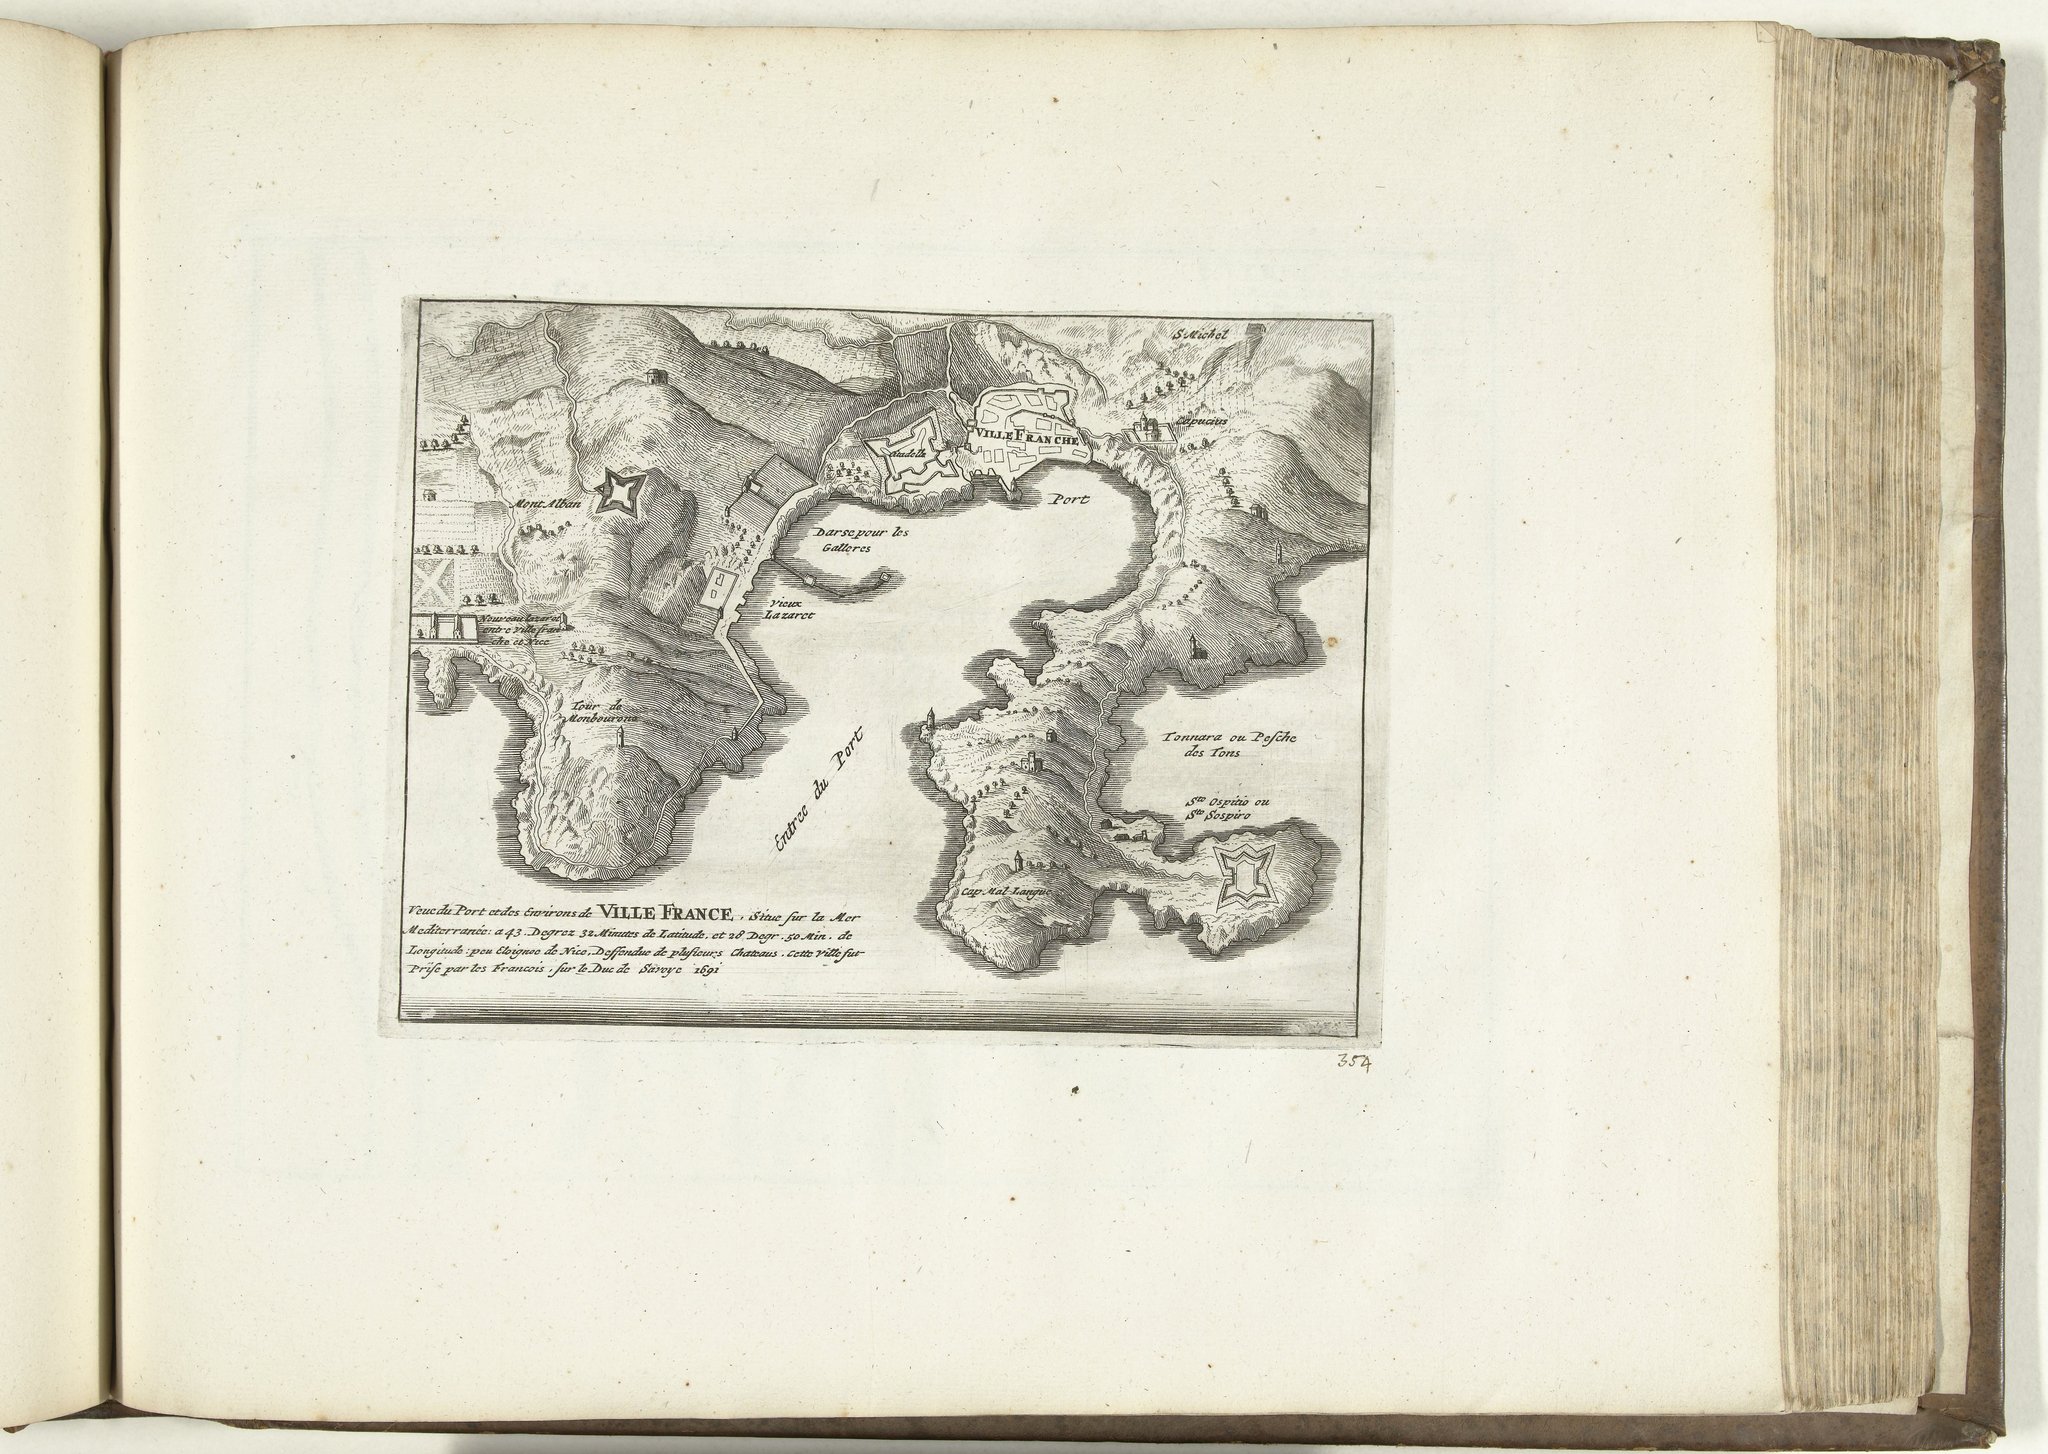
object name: print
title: Kaart van Villefranche-sur-Mer en omgeving, 1726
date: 1726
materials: paper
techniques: etching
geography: leiden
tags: maps of separate countries or regions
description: Kaart van de Franse kuststad Villefranche-sur-Mer en omgeving. Plaat nr. 354 in deel XV van het prentwerk: Les Forces de l'Europe, Asie, Afrique et Amerique ... Comme aussi les Cartes des Côtes de France et d'Espagne uit 1726, dit tweede deel met 271 met de hand genummerde platen van vermaarde sterke steden en vestingen in het kader van de Spaanse Successieoorlog 1701-1713. Voor het merendeel zijn deze platen gekopieerd naar de anonieme Franse platen van vermaarde sterke steden en vestingen: in Les forces de l'Europe en in: Le theatre de la guerre, dans les Pays-Bas, beide oorspronkelijk uitgegeven door Nicolas de Fer te Parijs (1693-1697) in het kader van de Negenjarige Oorlog. Titel en opschriften in het Frans. Rechtsonder sporen van het weggepolijste nummer: 175.